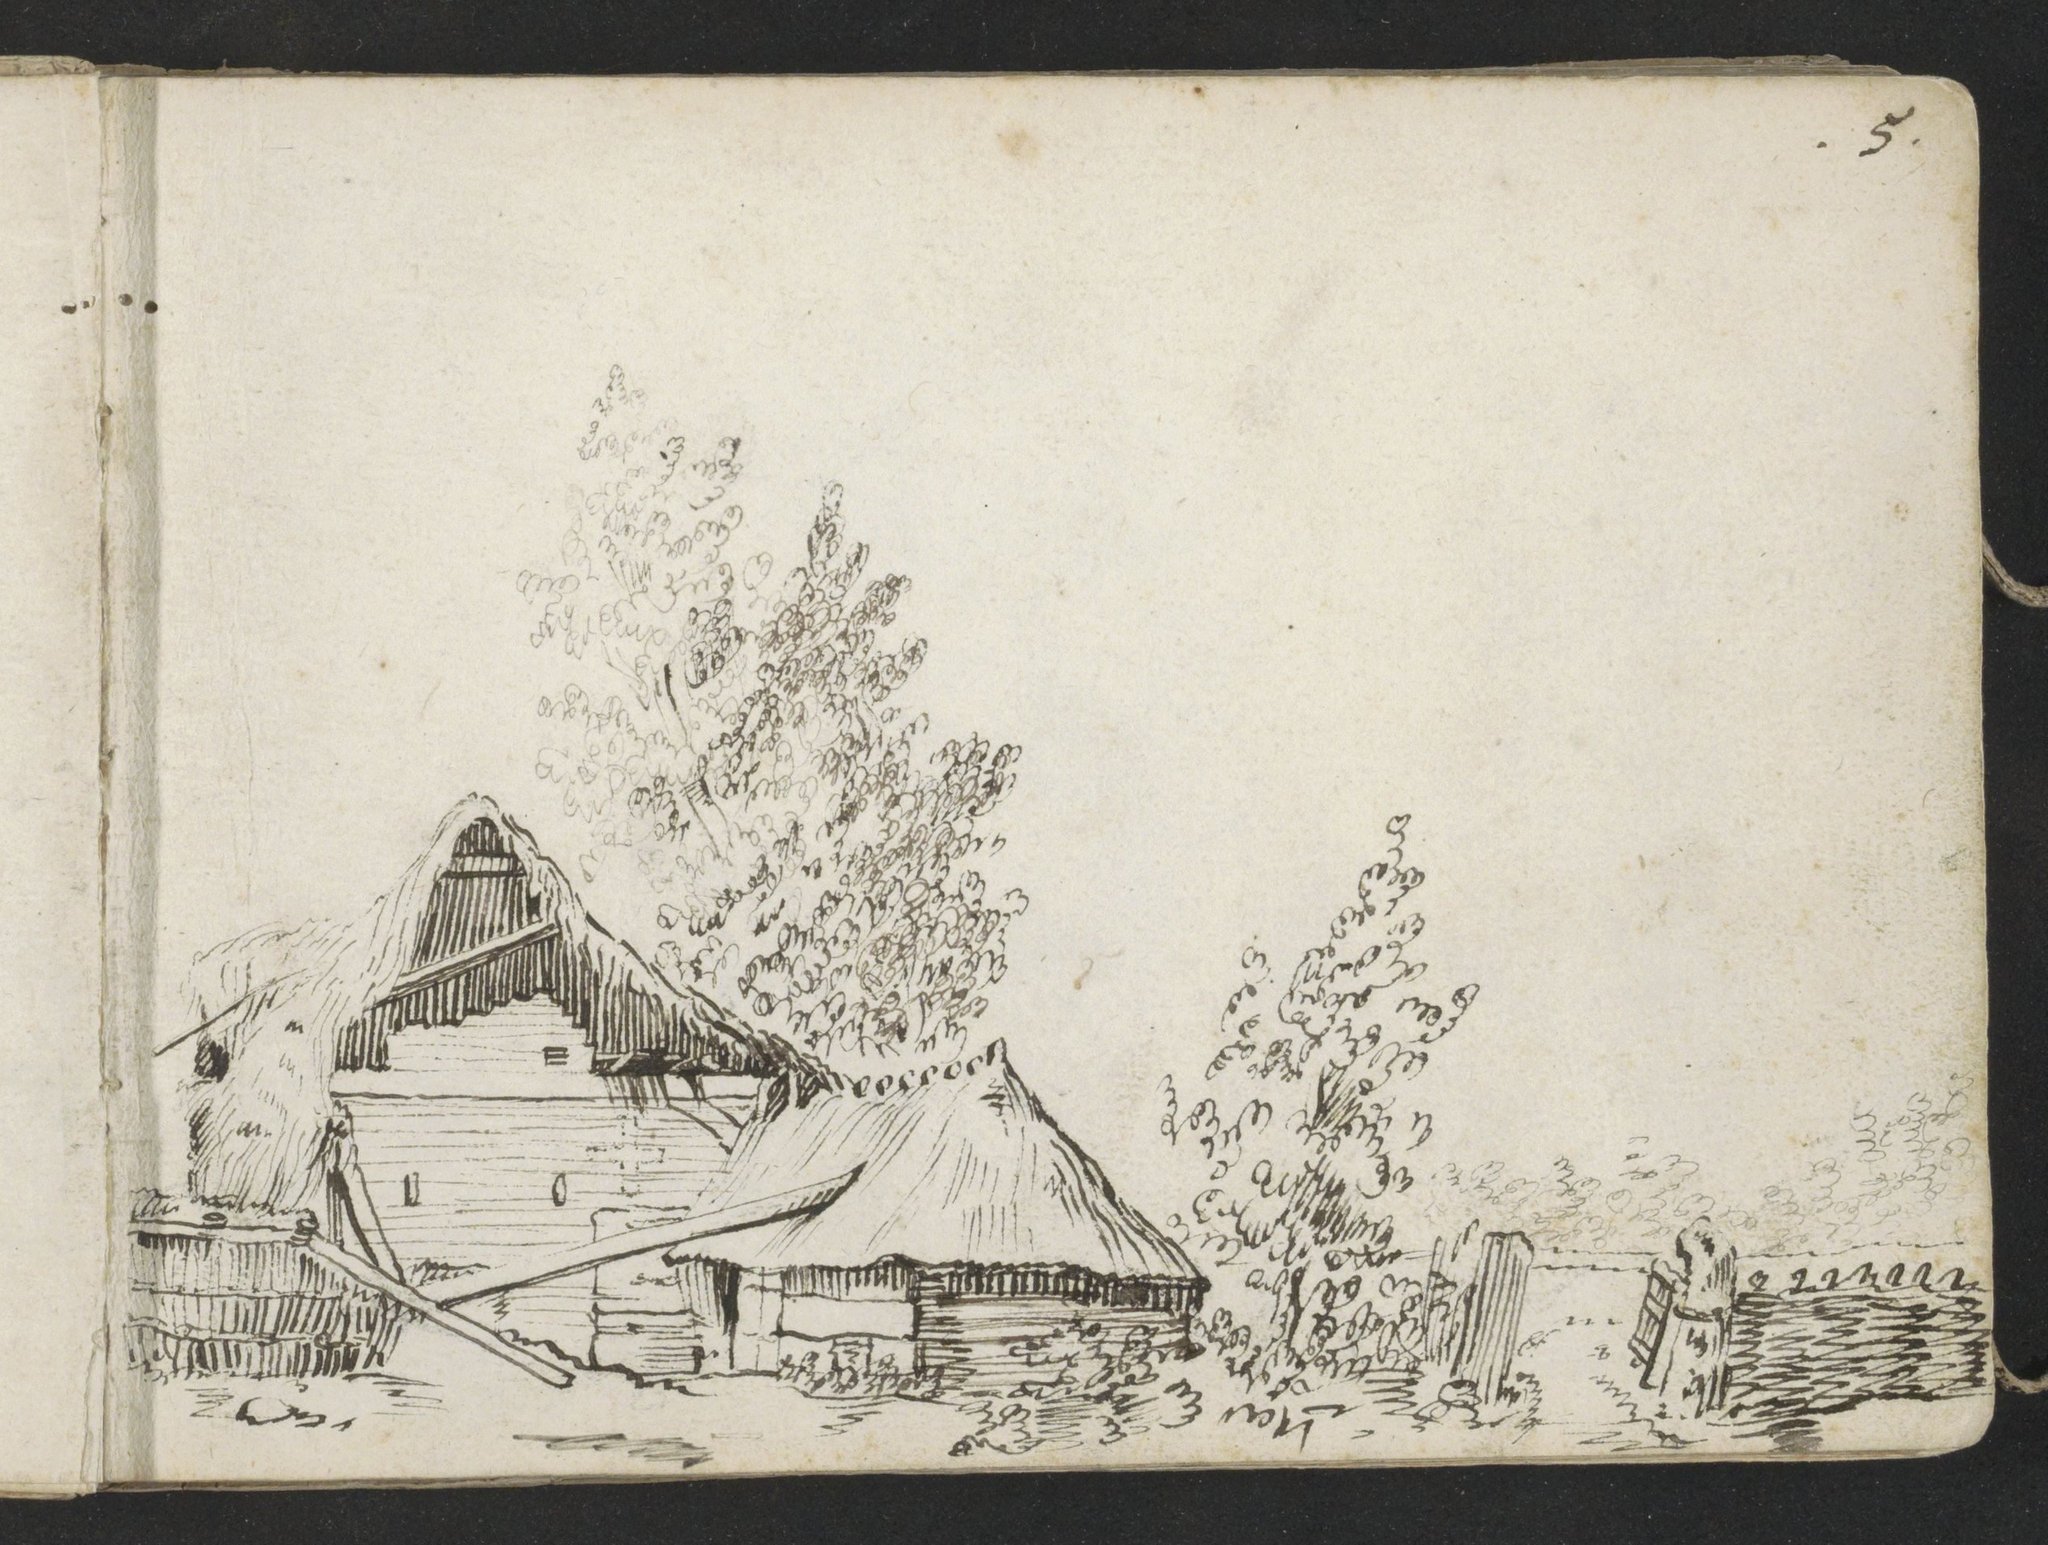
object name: sketchbook leaf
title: Vervallen boerenschuur buiten Zwolle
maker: gerard ter borch (ii)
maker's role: draughtsman, painter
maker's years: 1617-1681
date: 1631-1633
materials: ink, paper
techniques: pen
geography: zwolle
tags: barn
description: Blad 5 recto uit een schetsboek met 55 bladen.